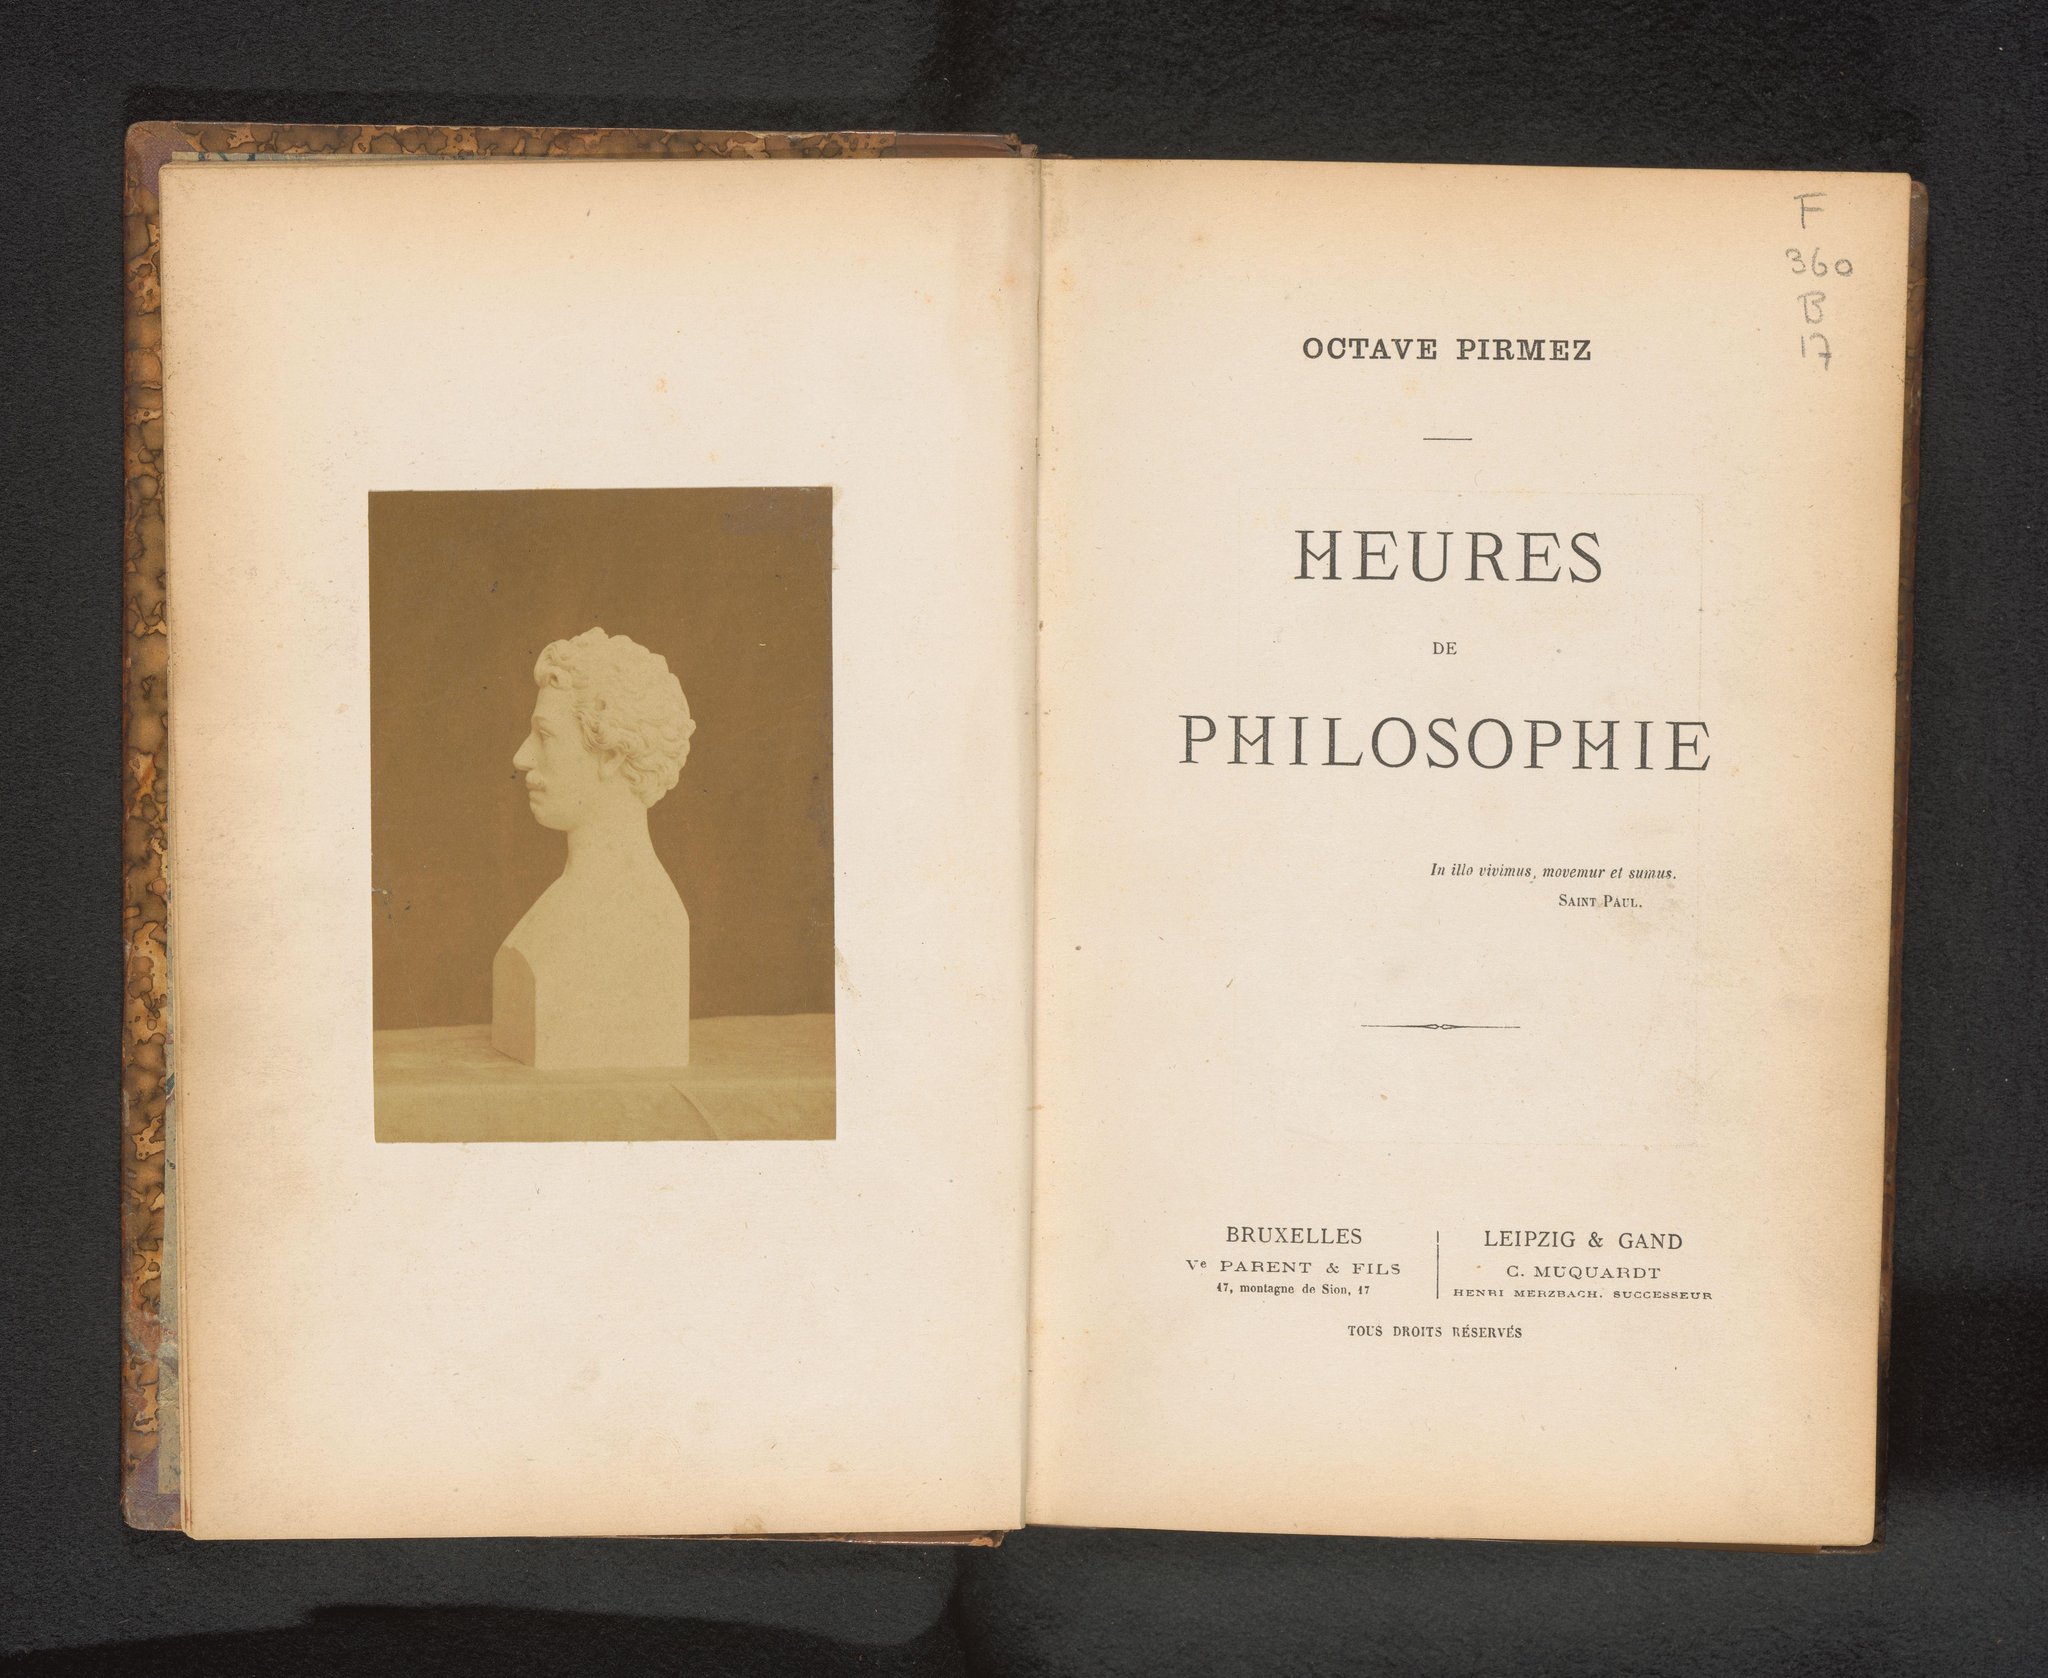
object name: page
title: Buste van Octave Pirmez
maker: Anonymous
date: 1868-1873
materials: photographic support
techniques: albumen print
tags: octave pirmez, historical persons, piece of sculpture, reproduction of a piece of sculpture